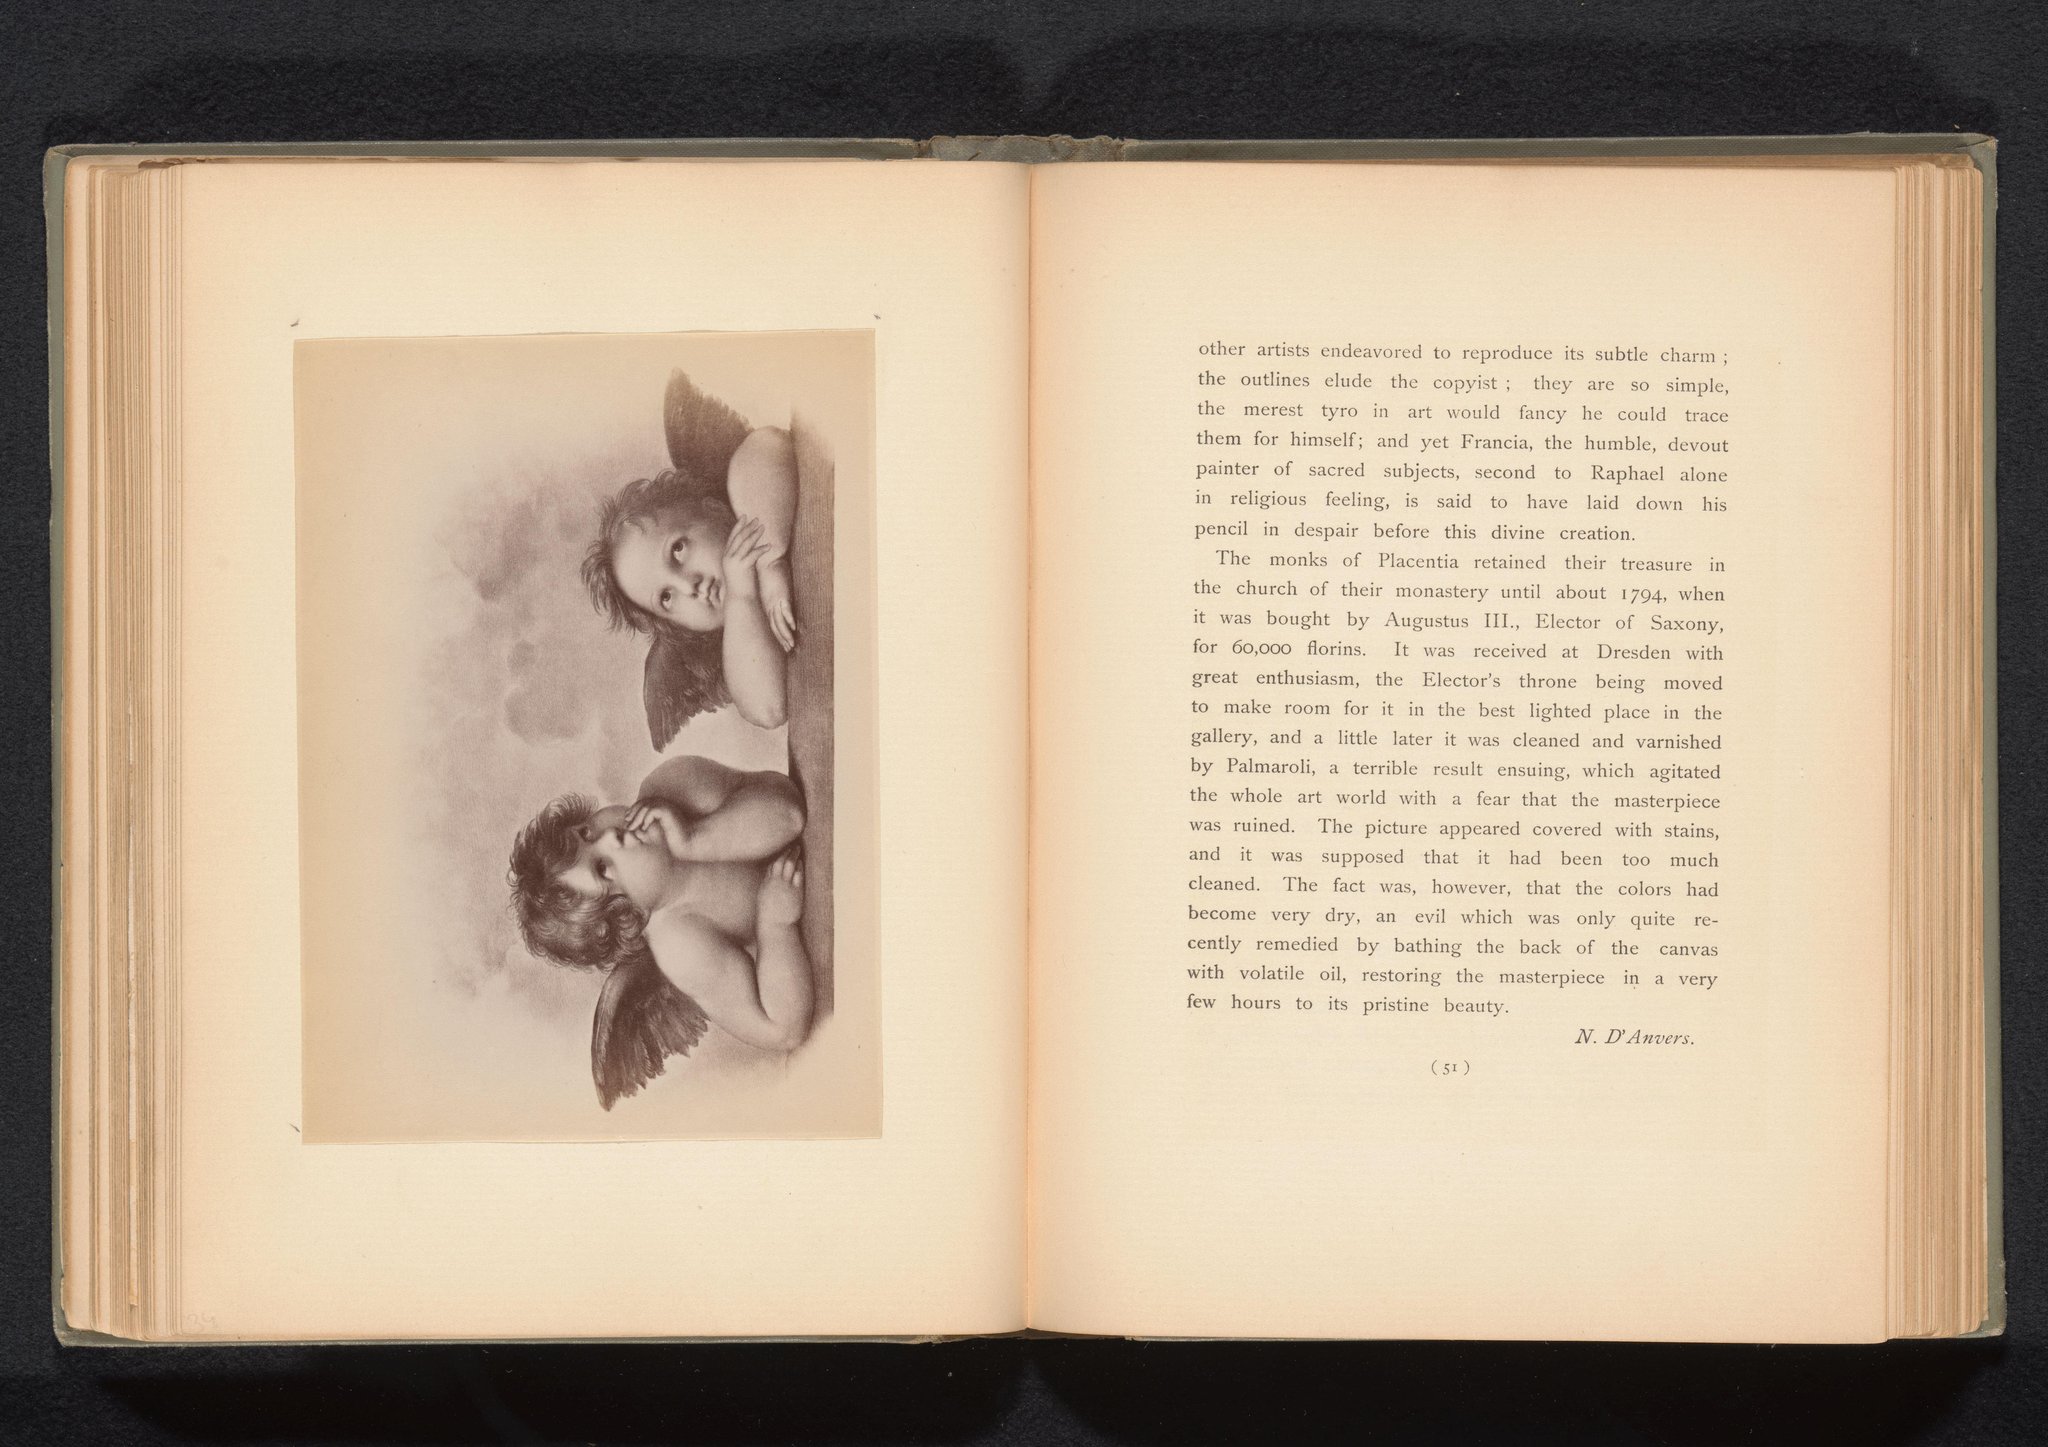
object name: page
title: Fotoreproductie van een prent naar een schilderij, voorstellende twee putti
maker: Anonymous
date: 1882-1887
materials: photographic support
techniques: albumen print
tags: cupids: 'amores', 'amoretti', 'putti'